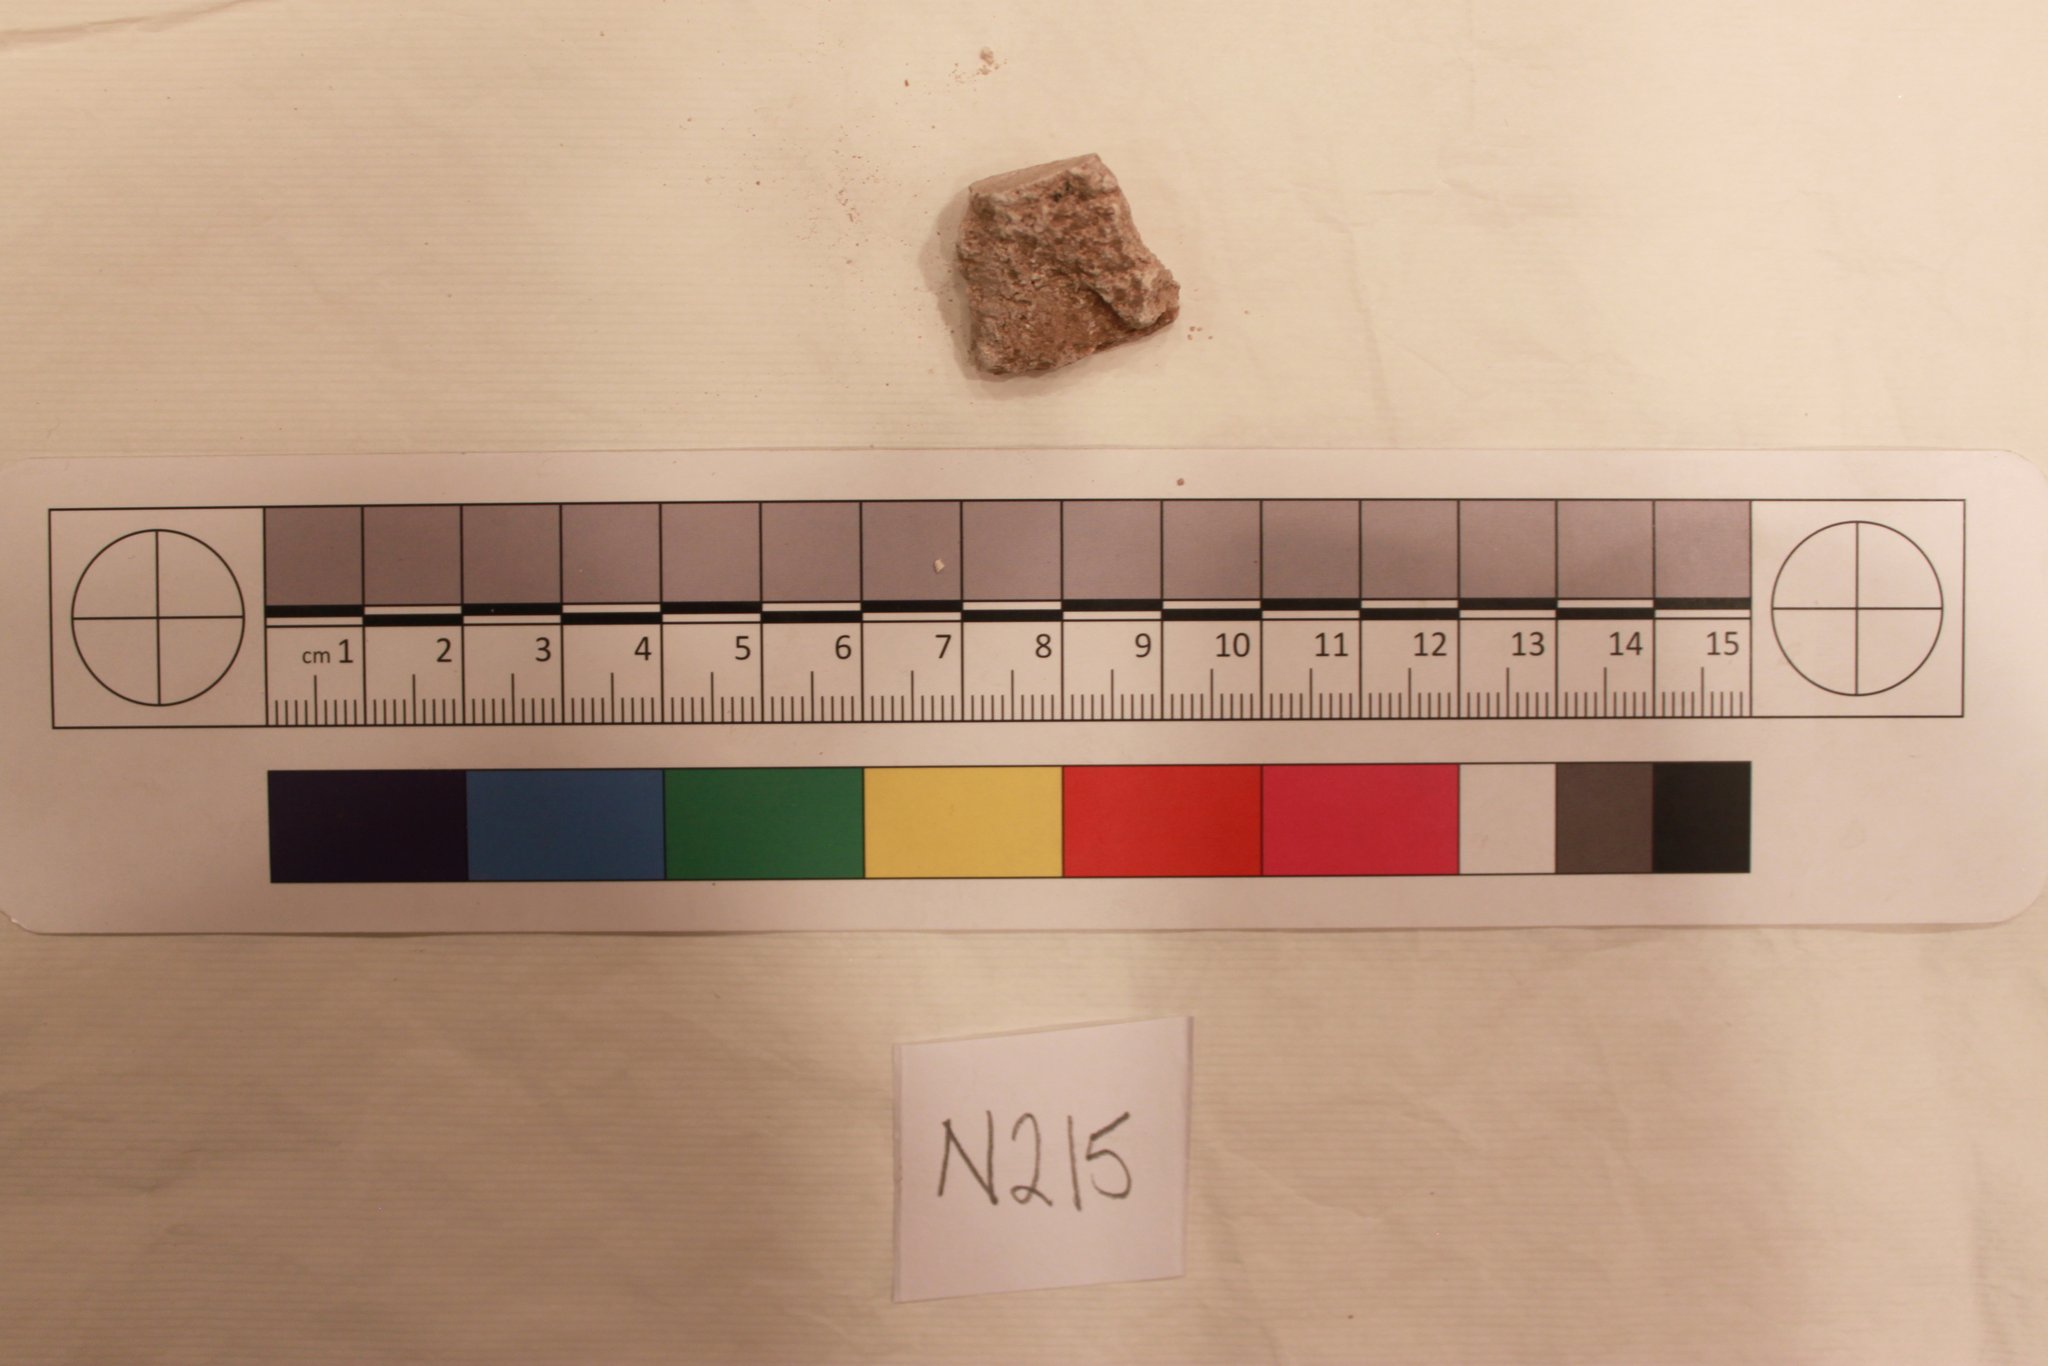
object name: fragment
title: Stucco Fragment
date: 701-1200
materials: plaster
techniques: carving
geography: iran